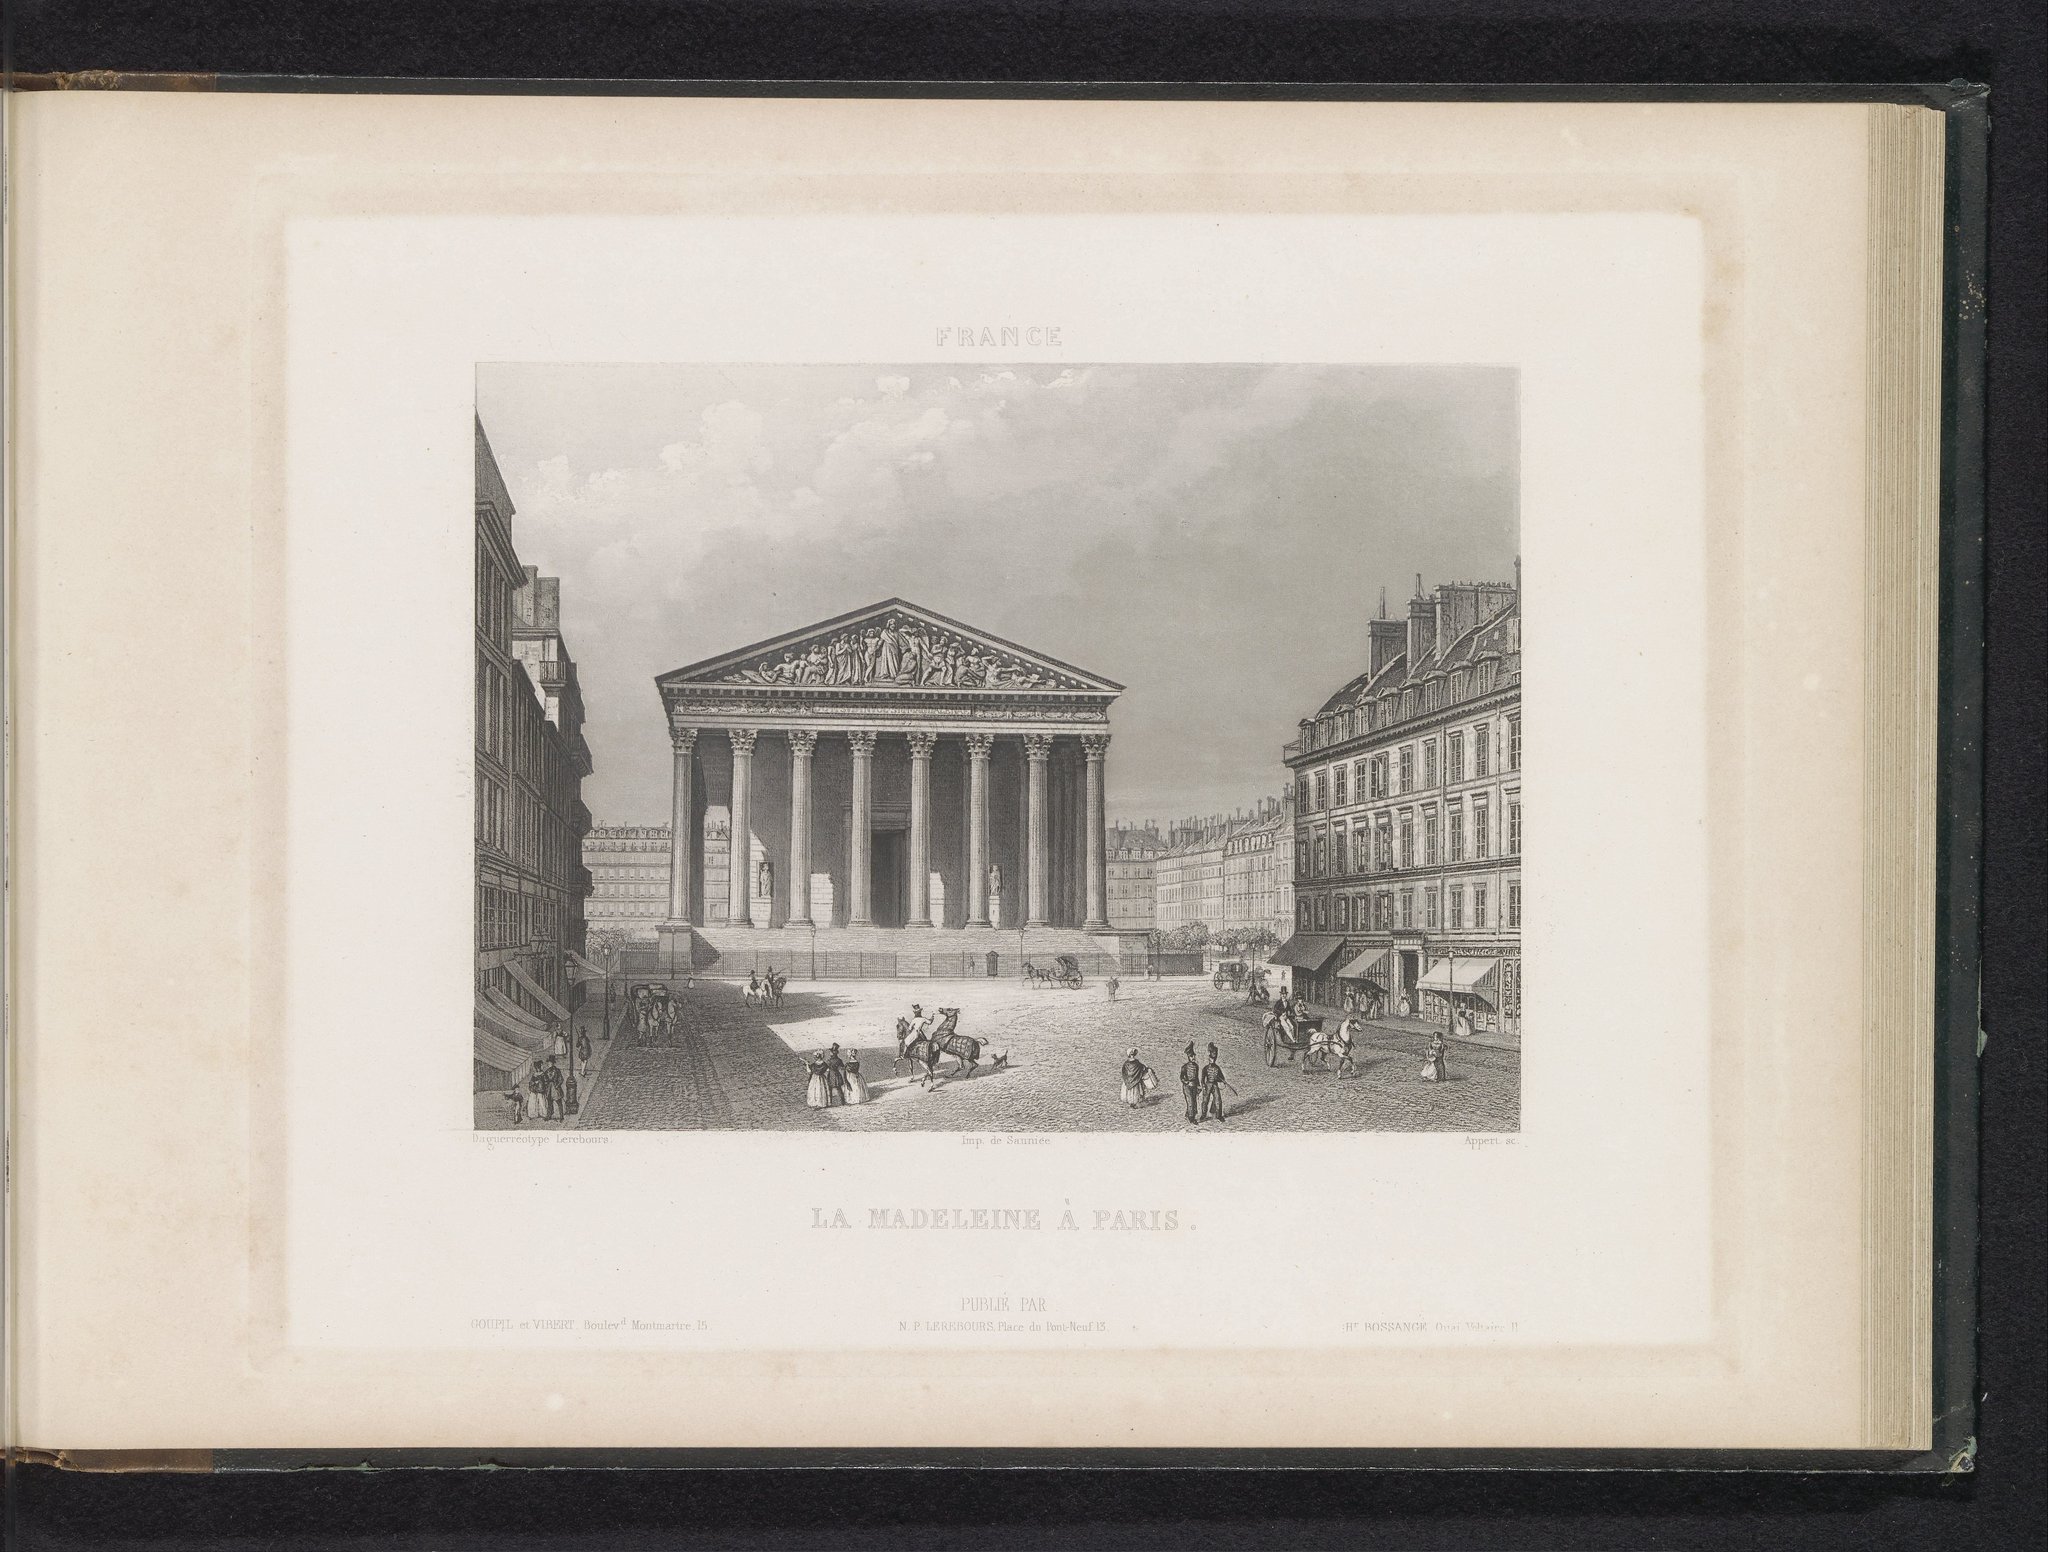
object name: print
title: Gezicht op La Madeleine te Parijs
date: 1839-1841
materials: paper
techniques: aquatint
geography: paris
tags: church (exterior), façade (of house or building)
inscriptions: inscription: ‘N.P. Lerebours Place du Pont Neuf 15’, inscription: ‘Rittner & Goupil Boulevd Montmartre 15’, inscription: ‘Hr. Bossance Quai Voltaire 11’